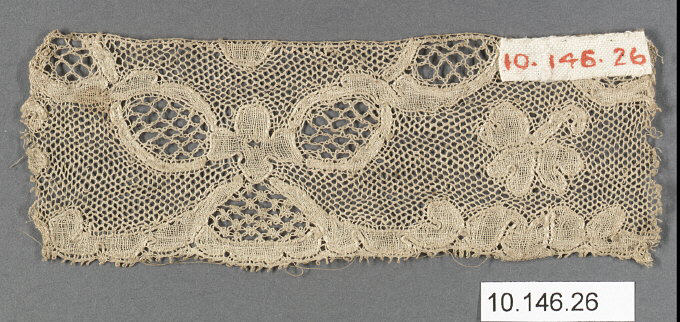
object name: fragment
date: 1701-1800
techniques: lace